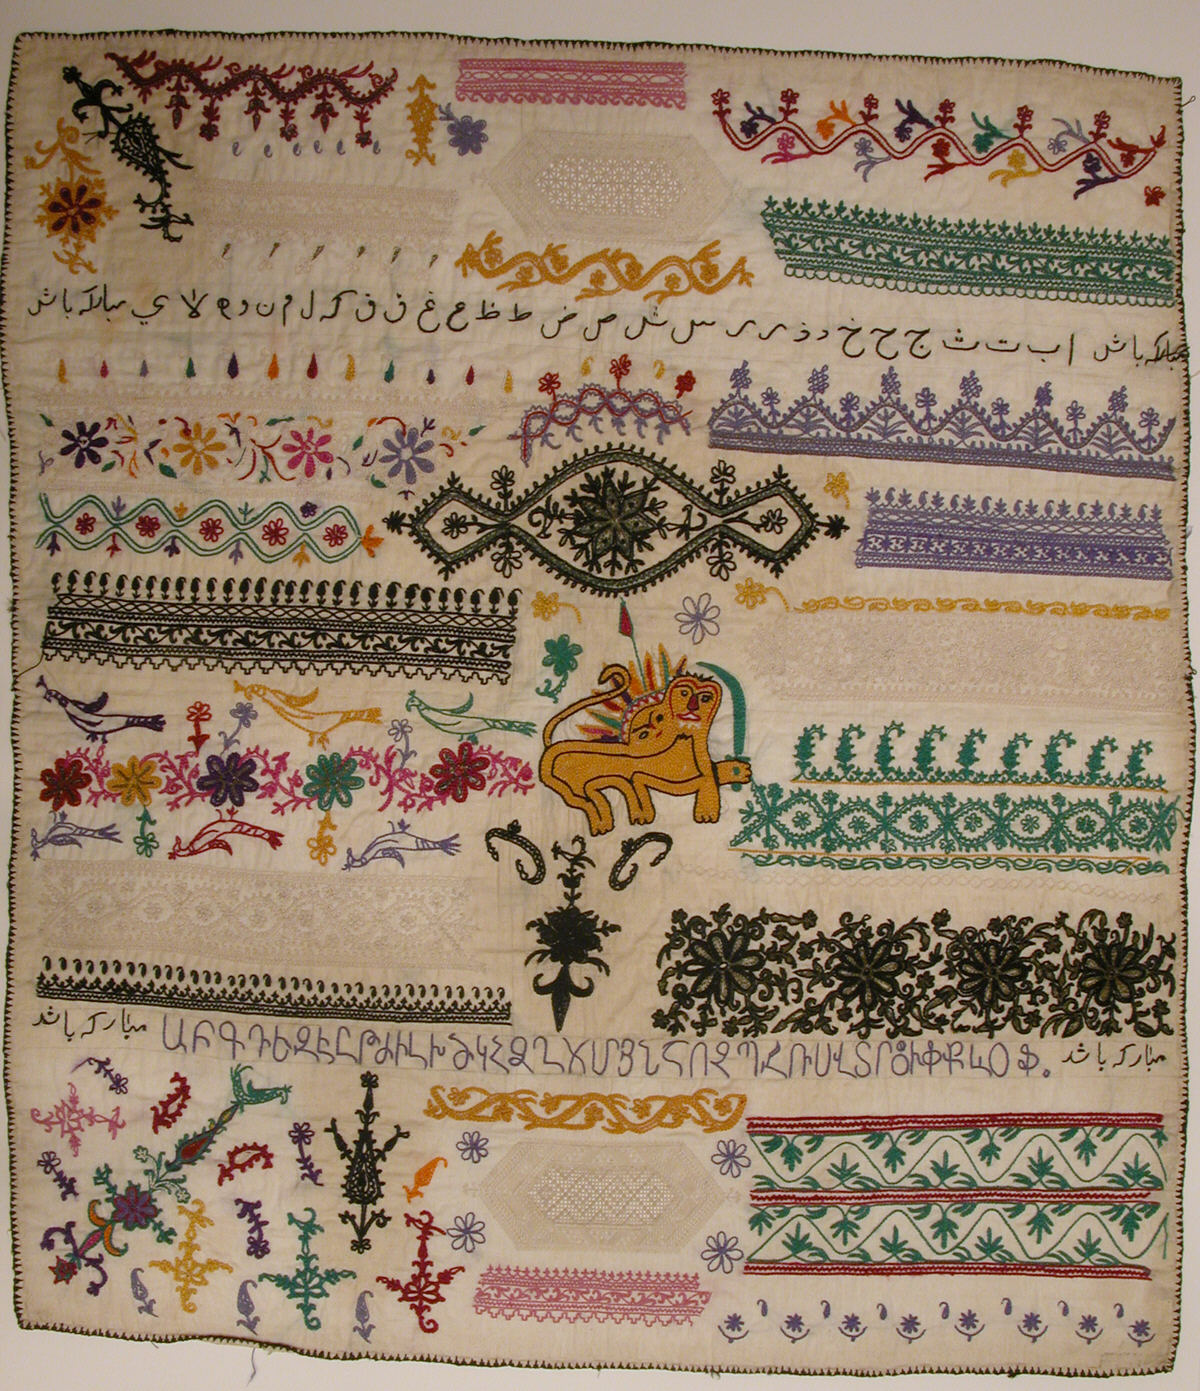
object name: sampler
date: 1867-1900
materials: linen, silk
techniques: embroidery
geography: iran